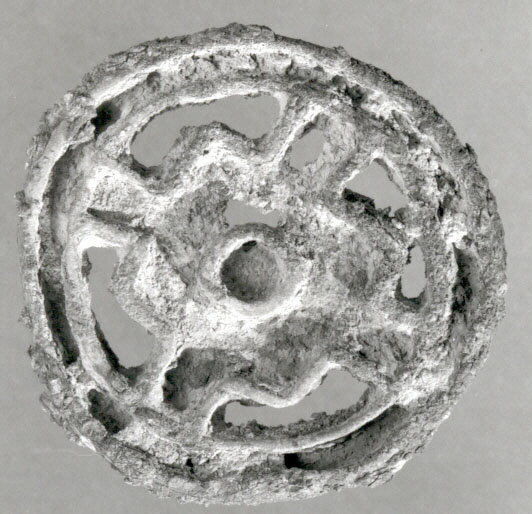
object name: stamp seal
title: Compartmented stamp seal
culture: bactria-margiana archaeological complex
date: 2333-1668 BCE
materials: copper alloy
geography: bactria-margiana